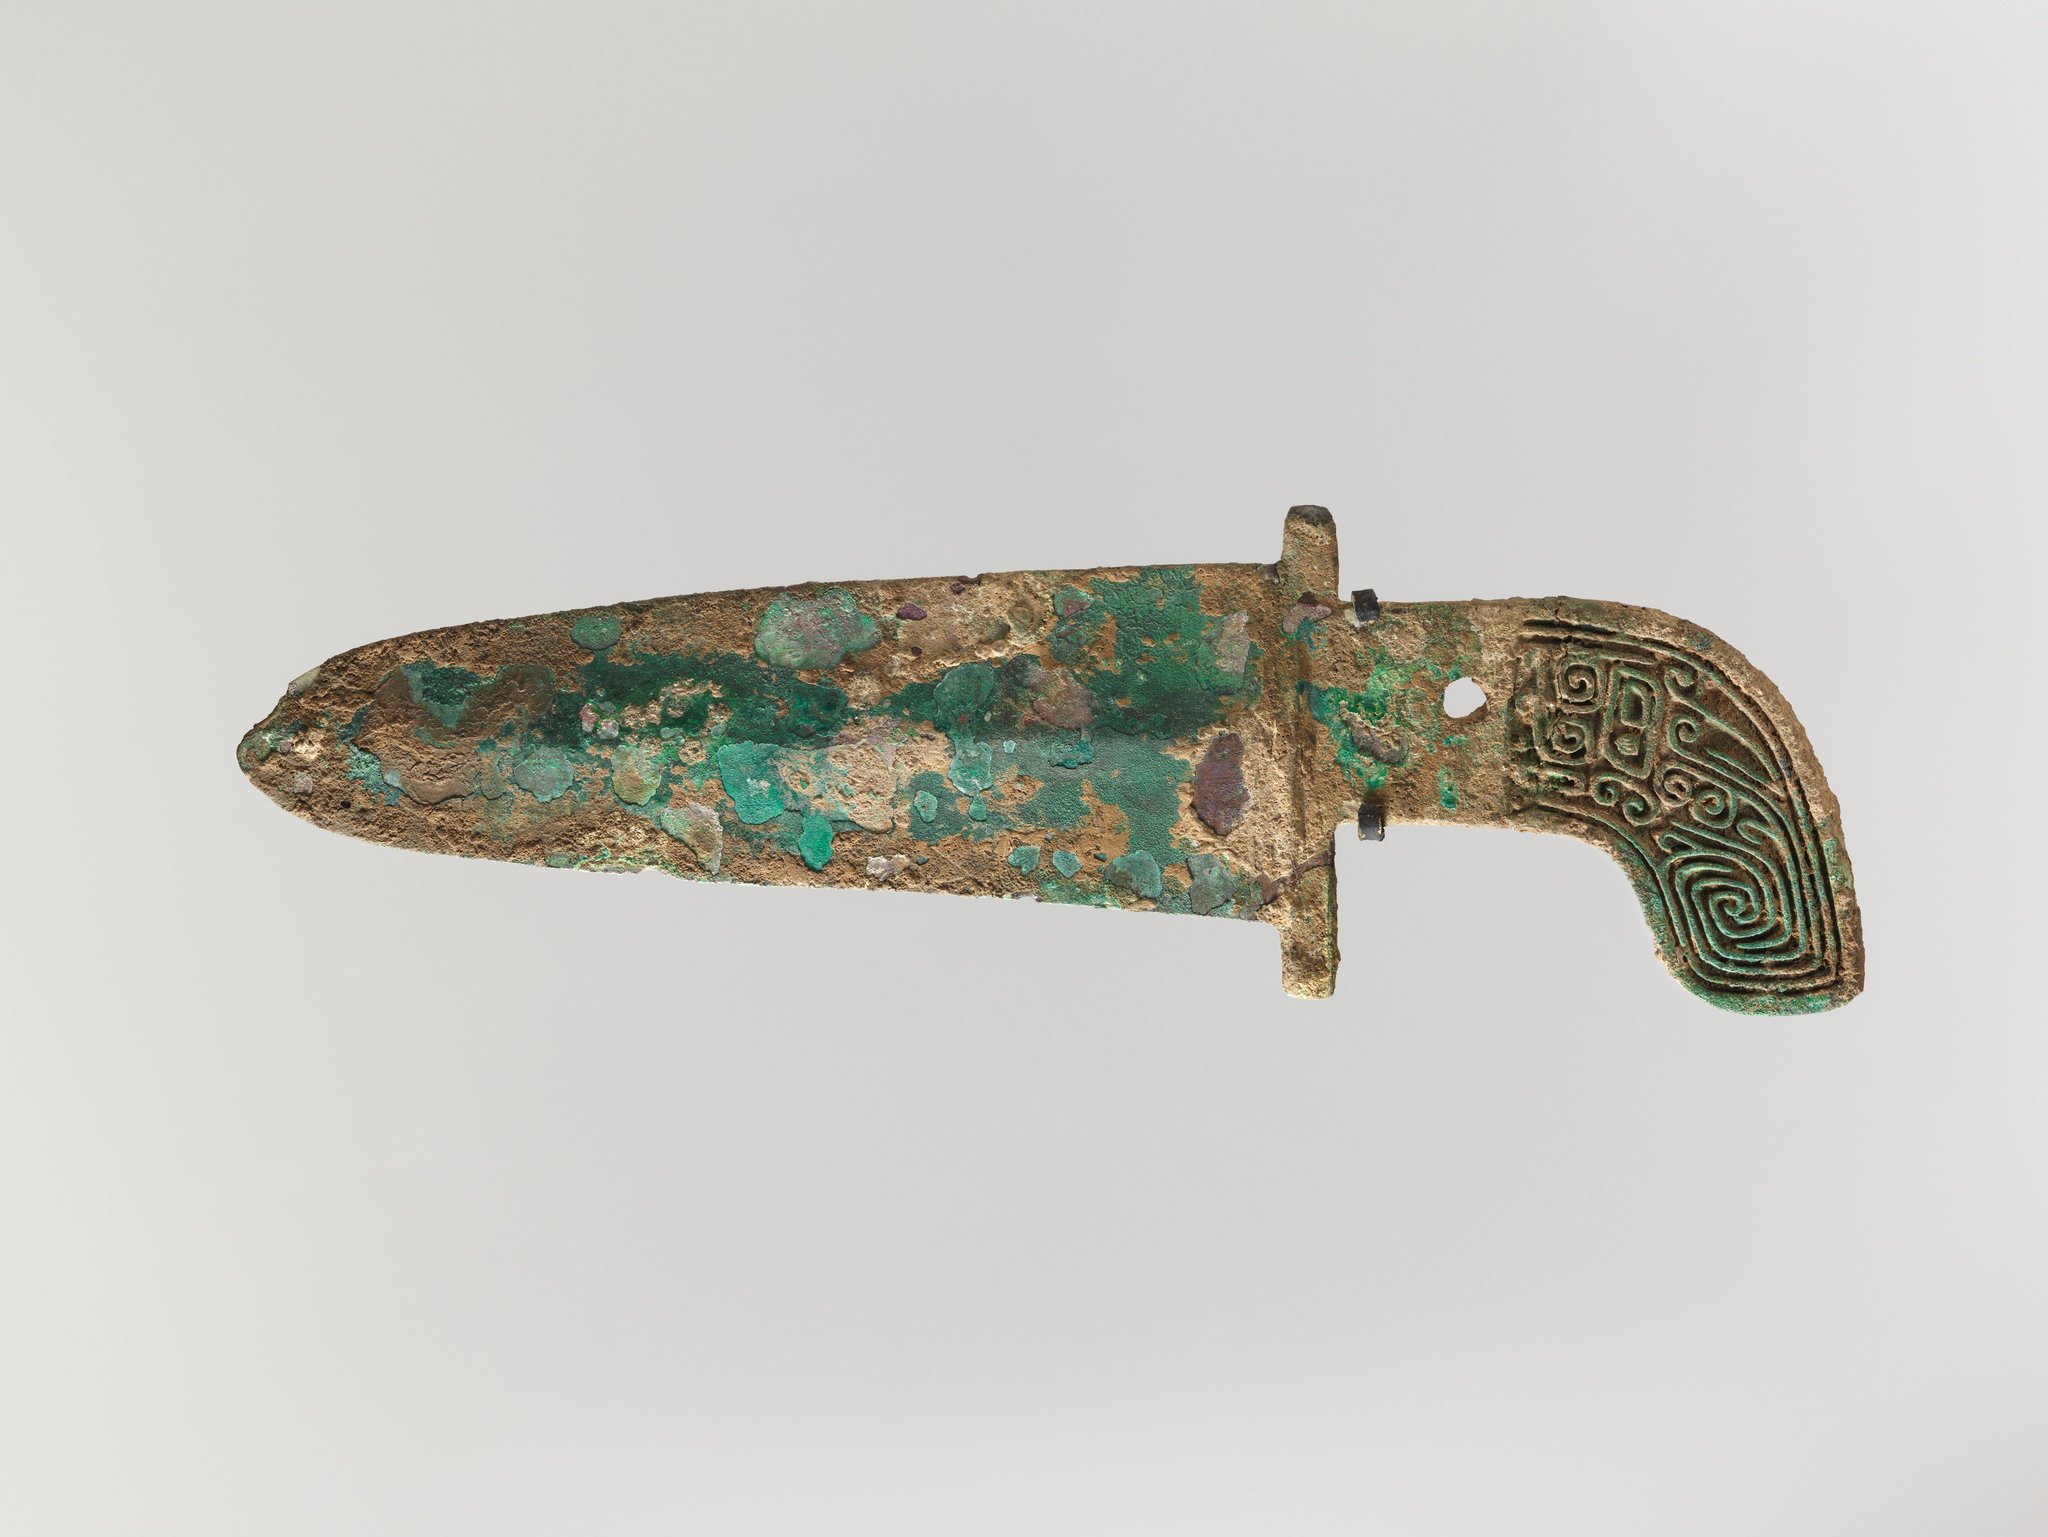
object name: dagger ax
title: Dagger-Ax (Ge)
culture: chinese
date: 1600-1046 BCE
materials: bronze